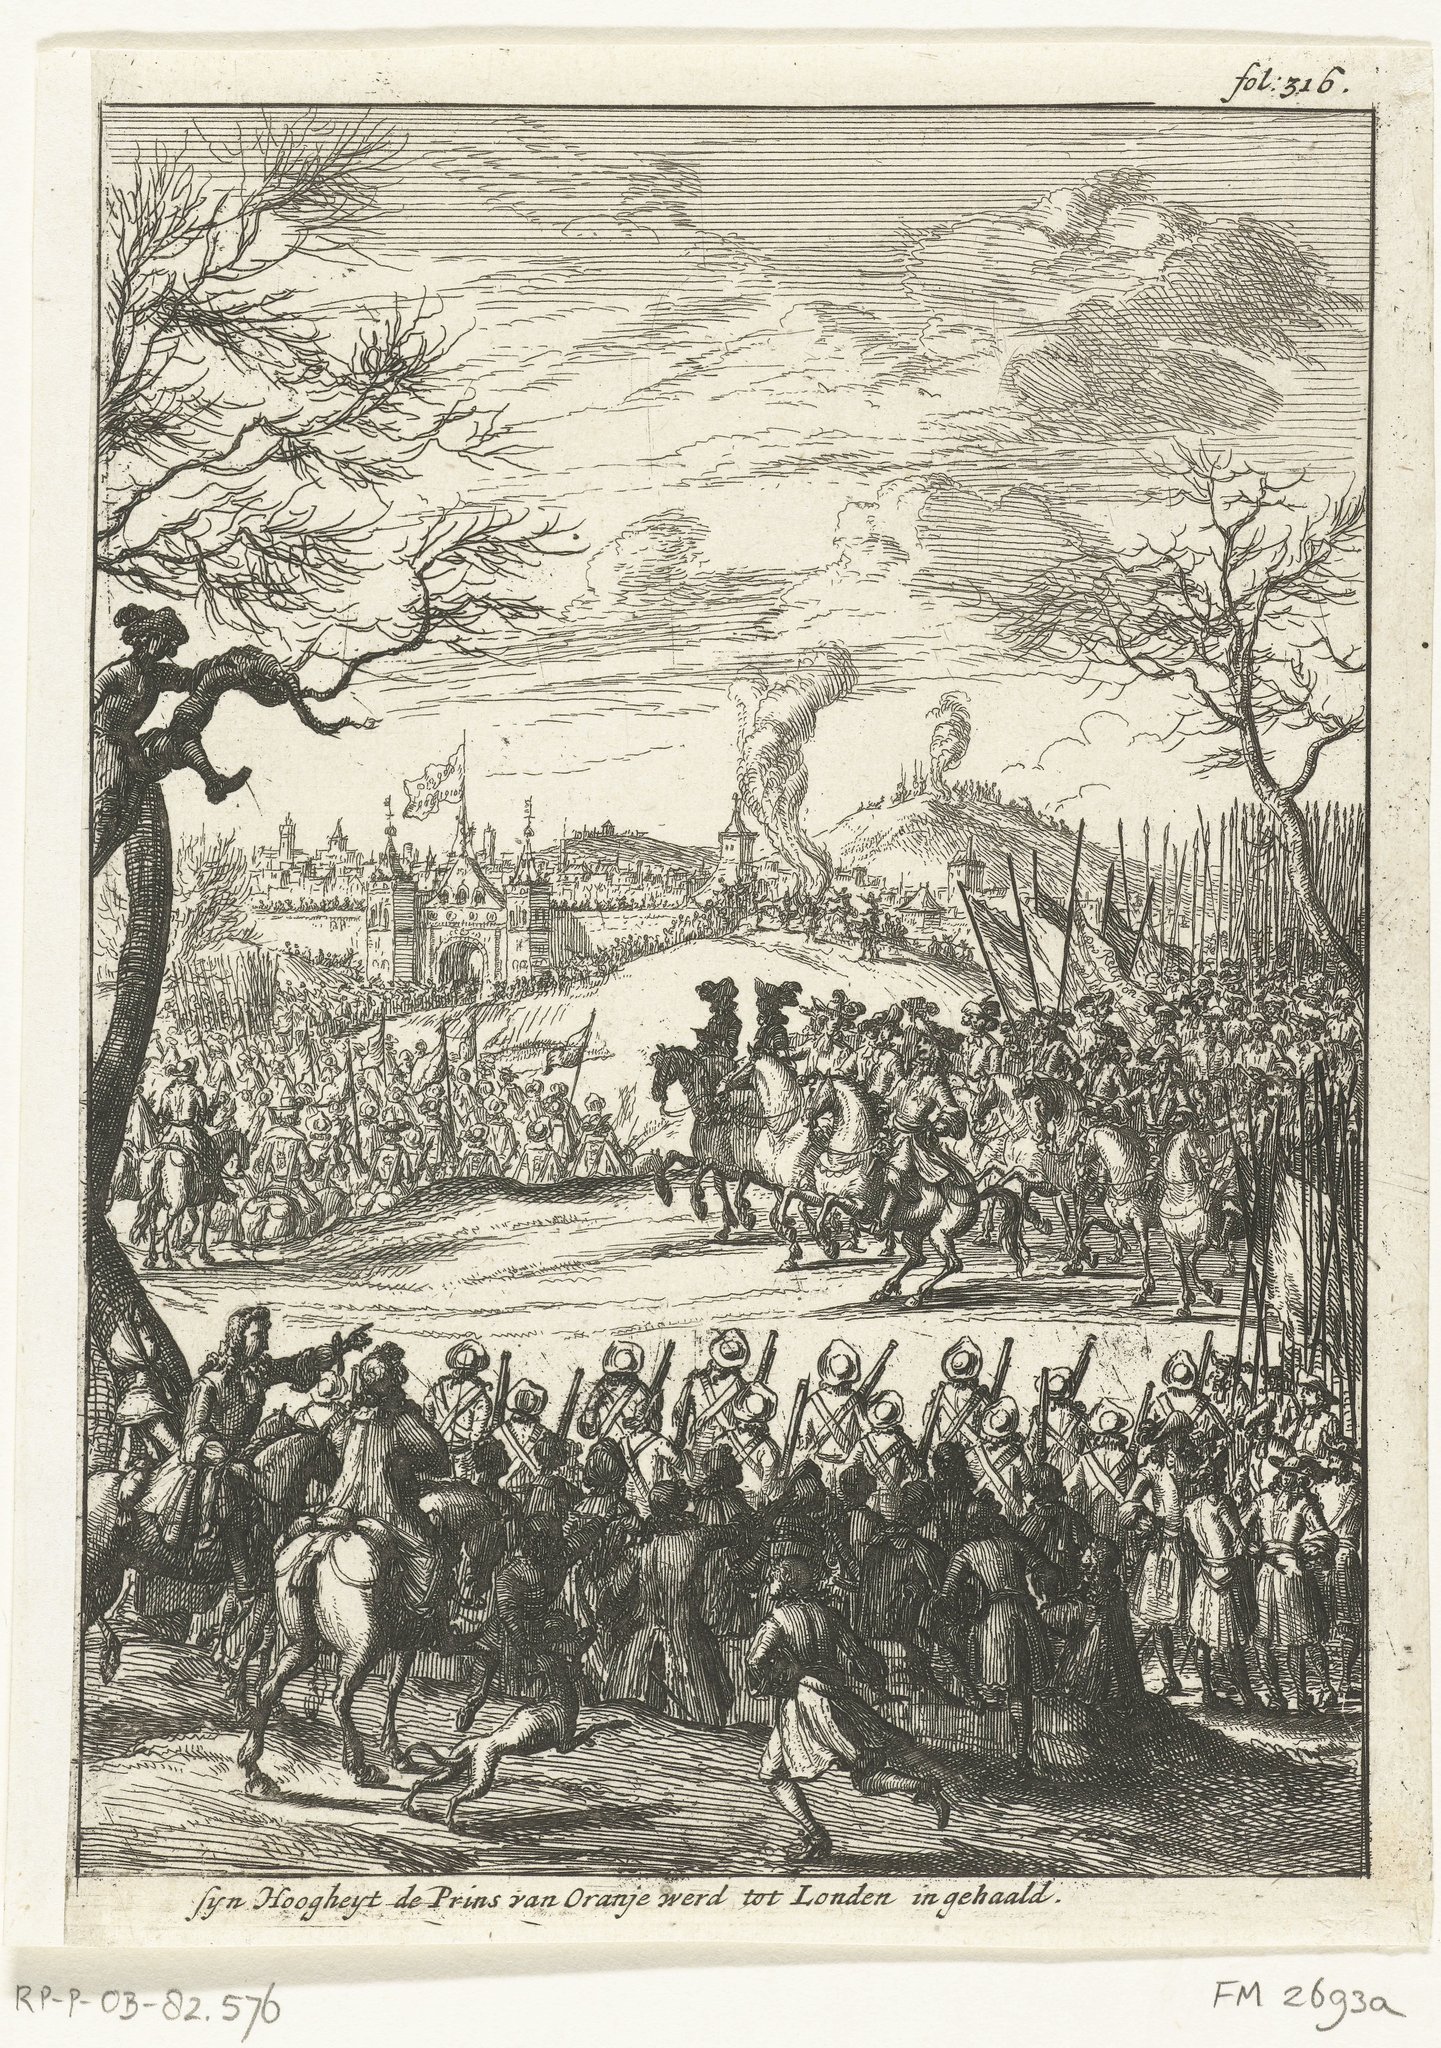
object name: print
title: syn Hoogheyt de Prins van Oranje werd tot Londen ingehaald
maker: Anonymous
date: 1689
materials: paper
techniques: etching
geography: northern netherlands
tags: william iii (prince of orange and king of england, scotland, and ireland), triumphal entry and public reception, pageant, 'entrée solennelle', 'joyeuse entrée', london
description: Gebruikt als illustratie in: Engeland beroerd onder de regeering van koning Jacobus de II. En hersteld door Willem en Maria, prins en princesse van Orangie, Jan Claesz ten Hoorn, Amsterdam 1689, fol. 316.